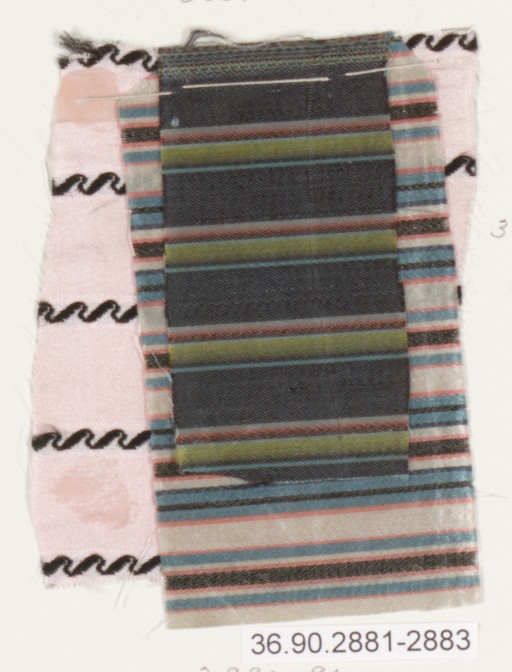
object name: piece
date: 1801-1900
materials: silk